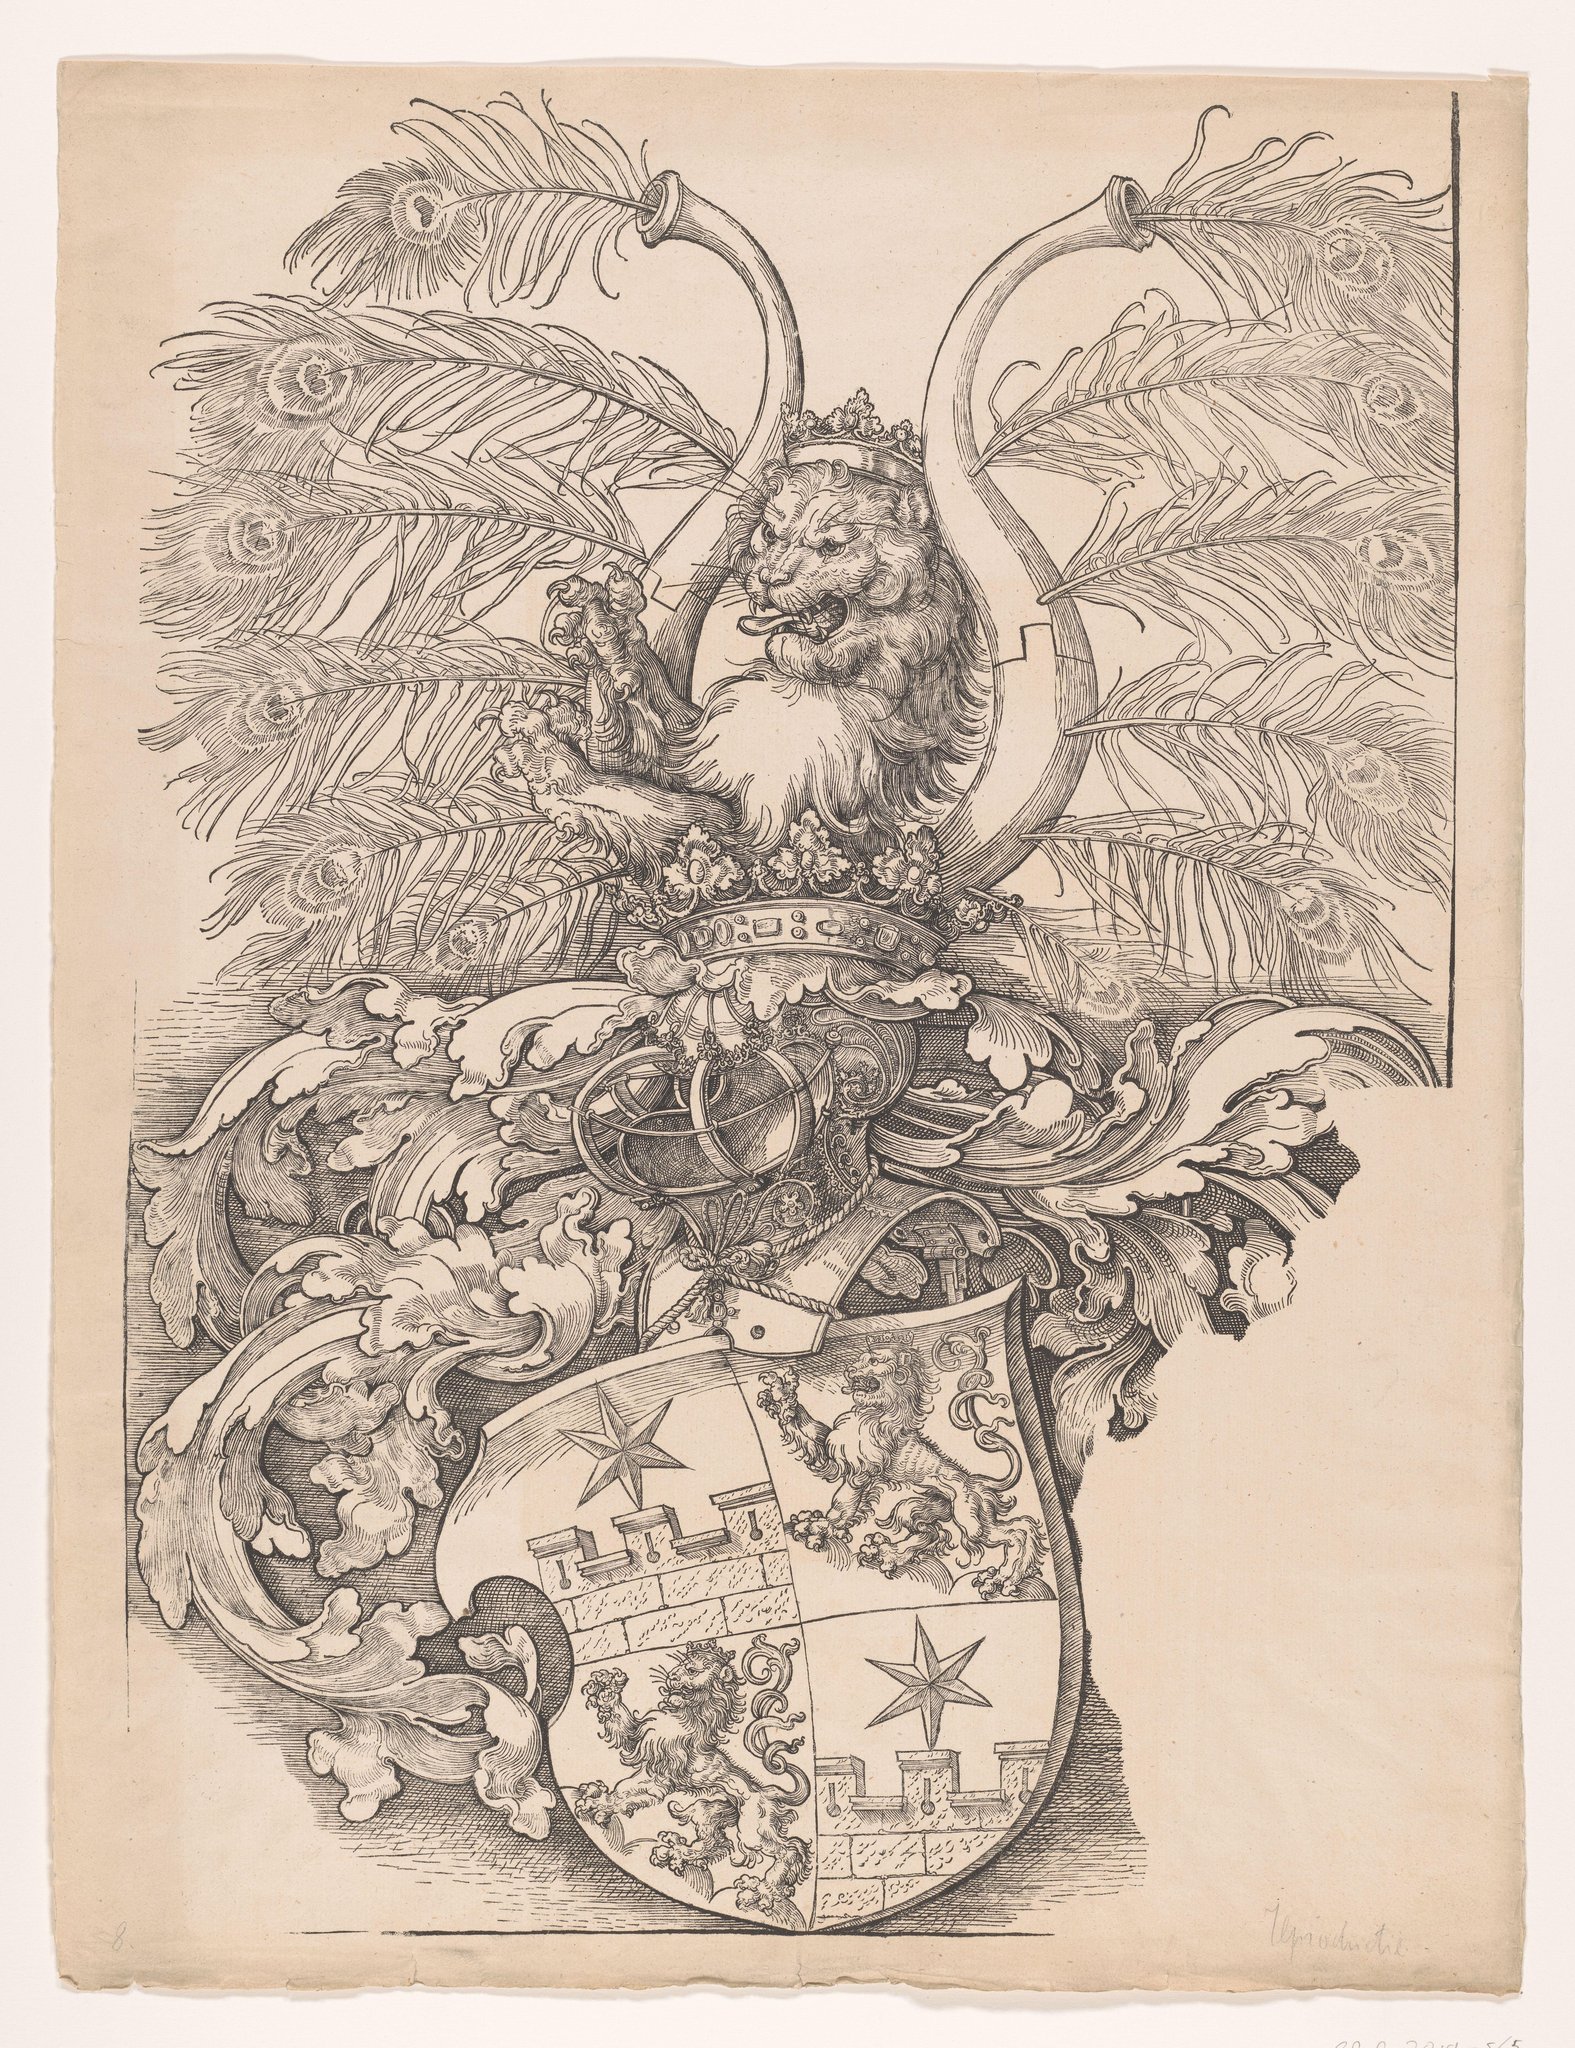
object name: print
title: Familiewapen van Rogendorf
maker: Anonymous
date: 1850-1949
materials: paper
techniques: woodcut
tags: armorial bearing, heraldry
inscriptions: : ‘8 reproductie’